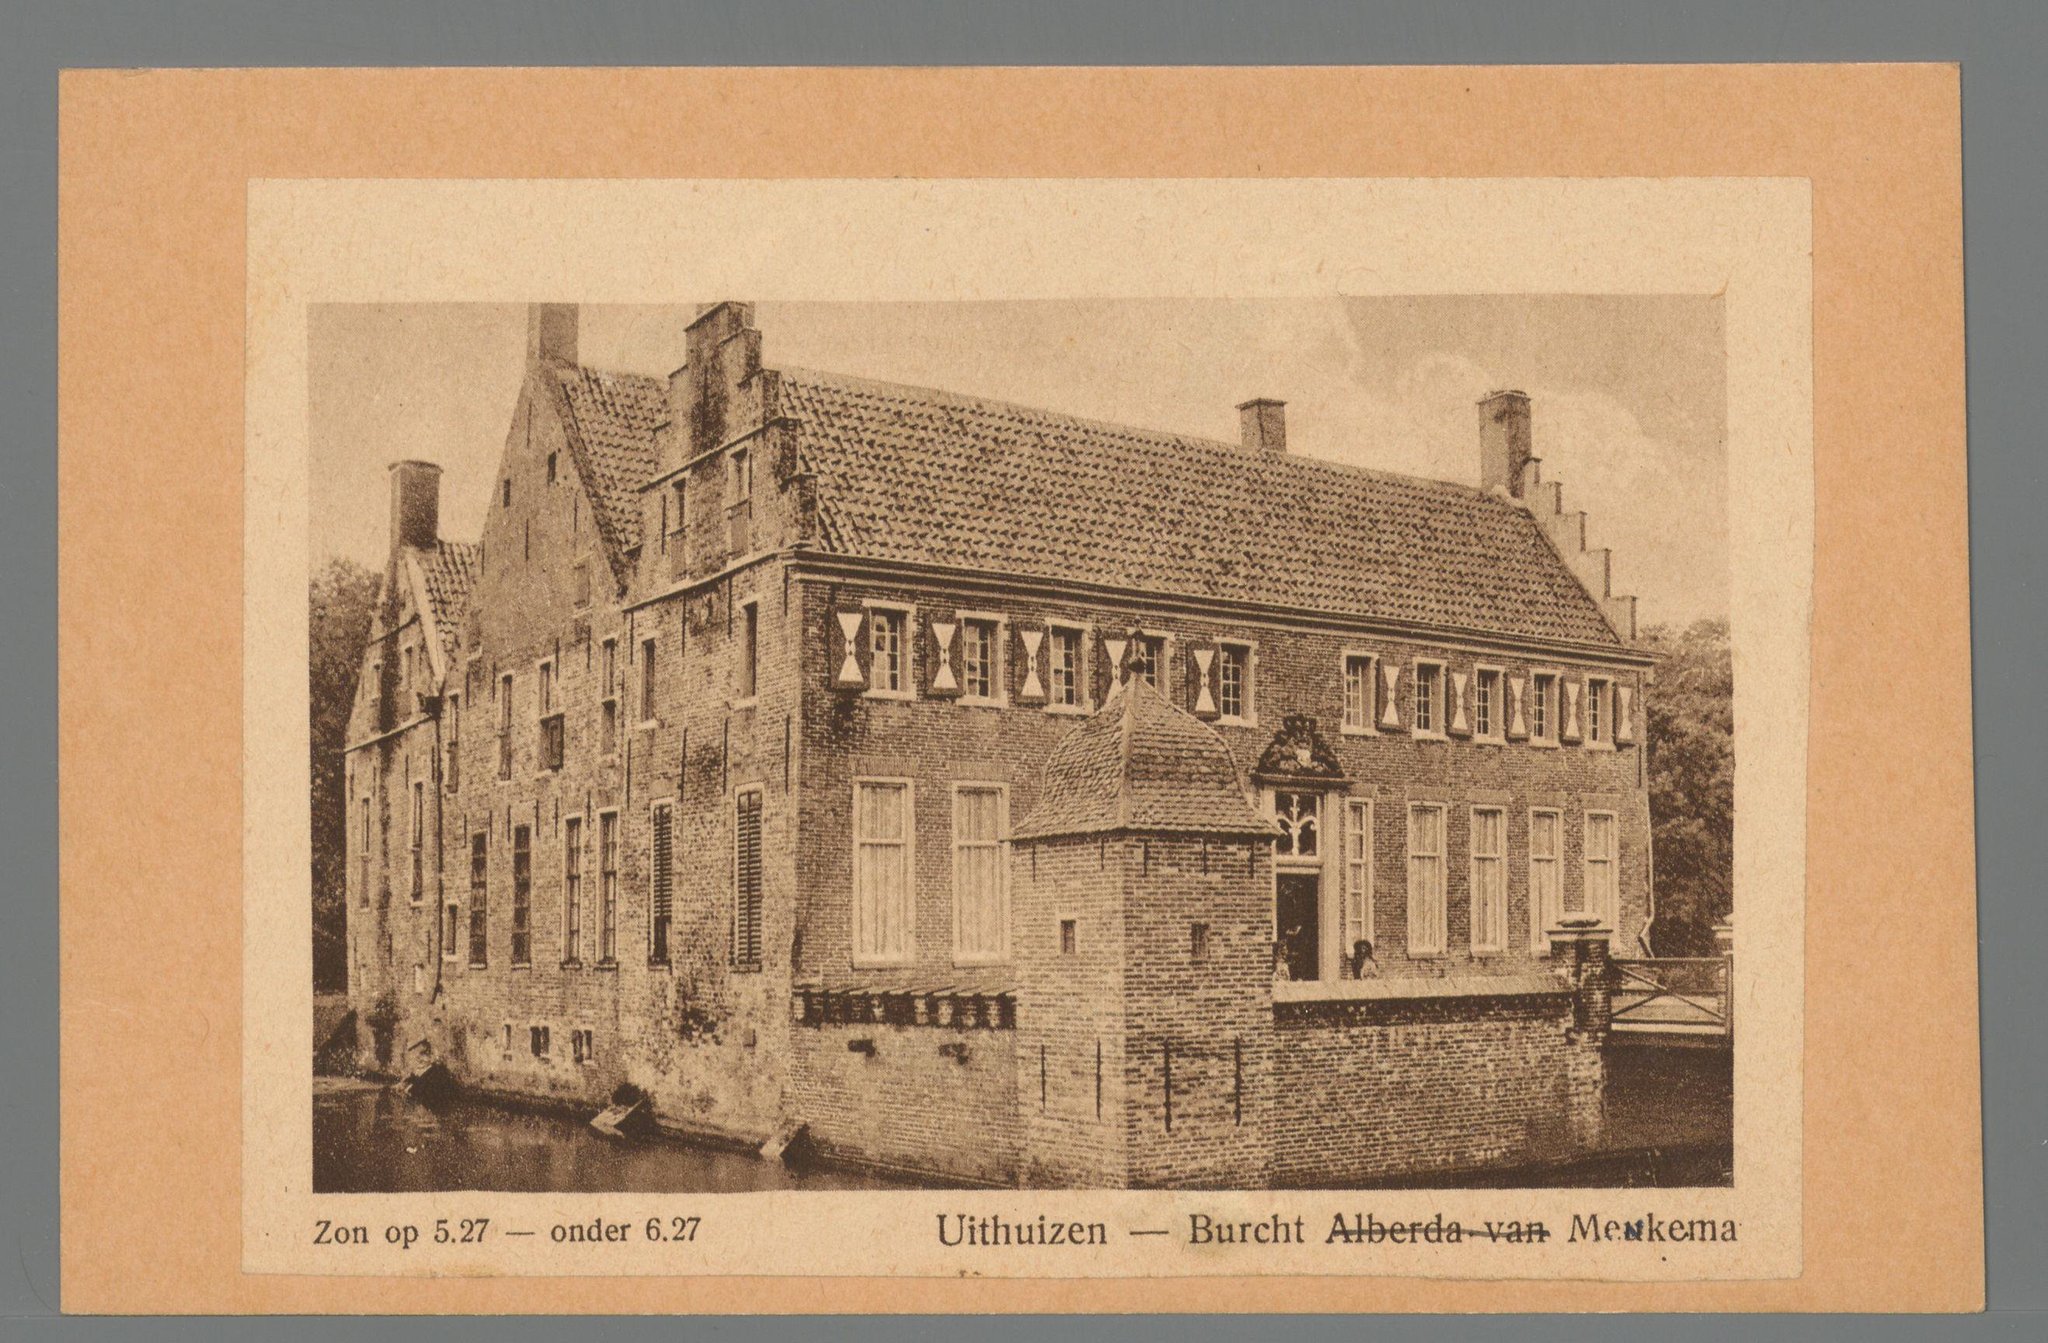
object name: ansichtkaart, prentbriefkaart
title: Uithuizen - Burcht Alberda van Meukema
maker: Anonymous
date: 1895-1930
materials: cardboard, paper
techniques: rotogravure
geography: uithuizen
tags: castle